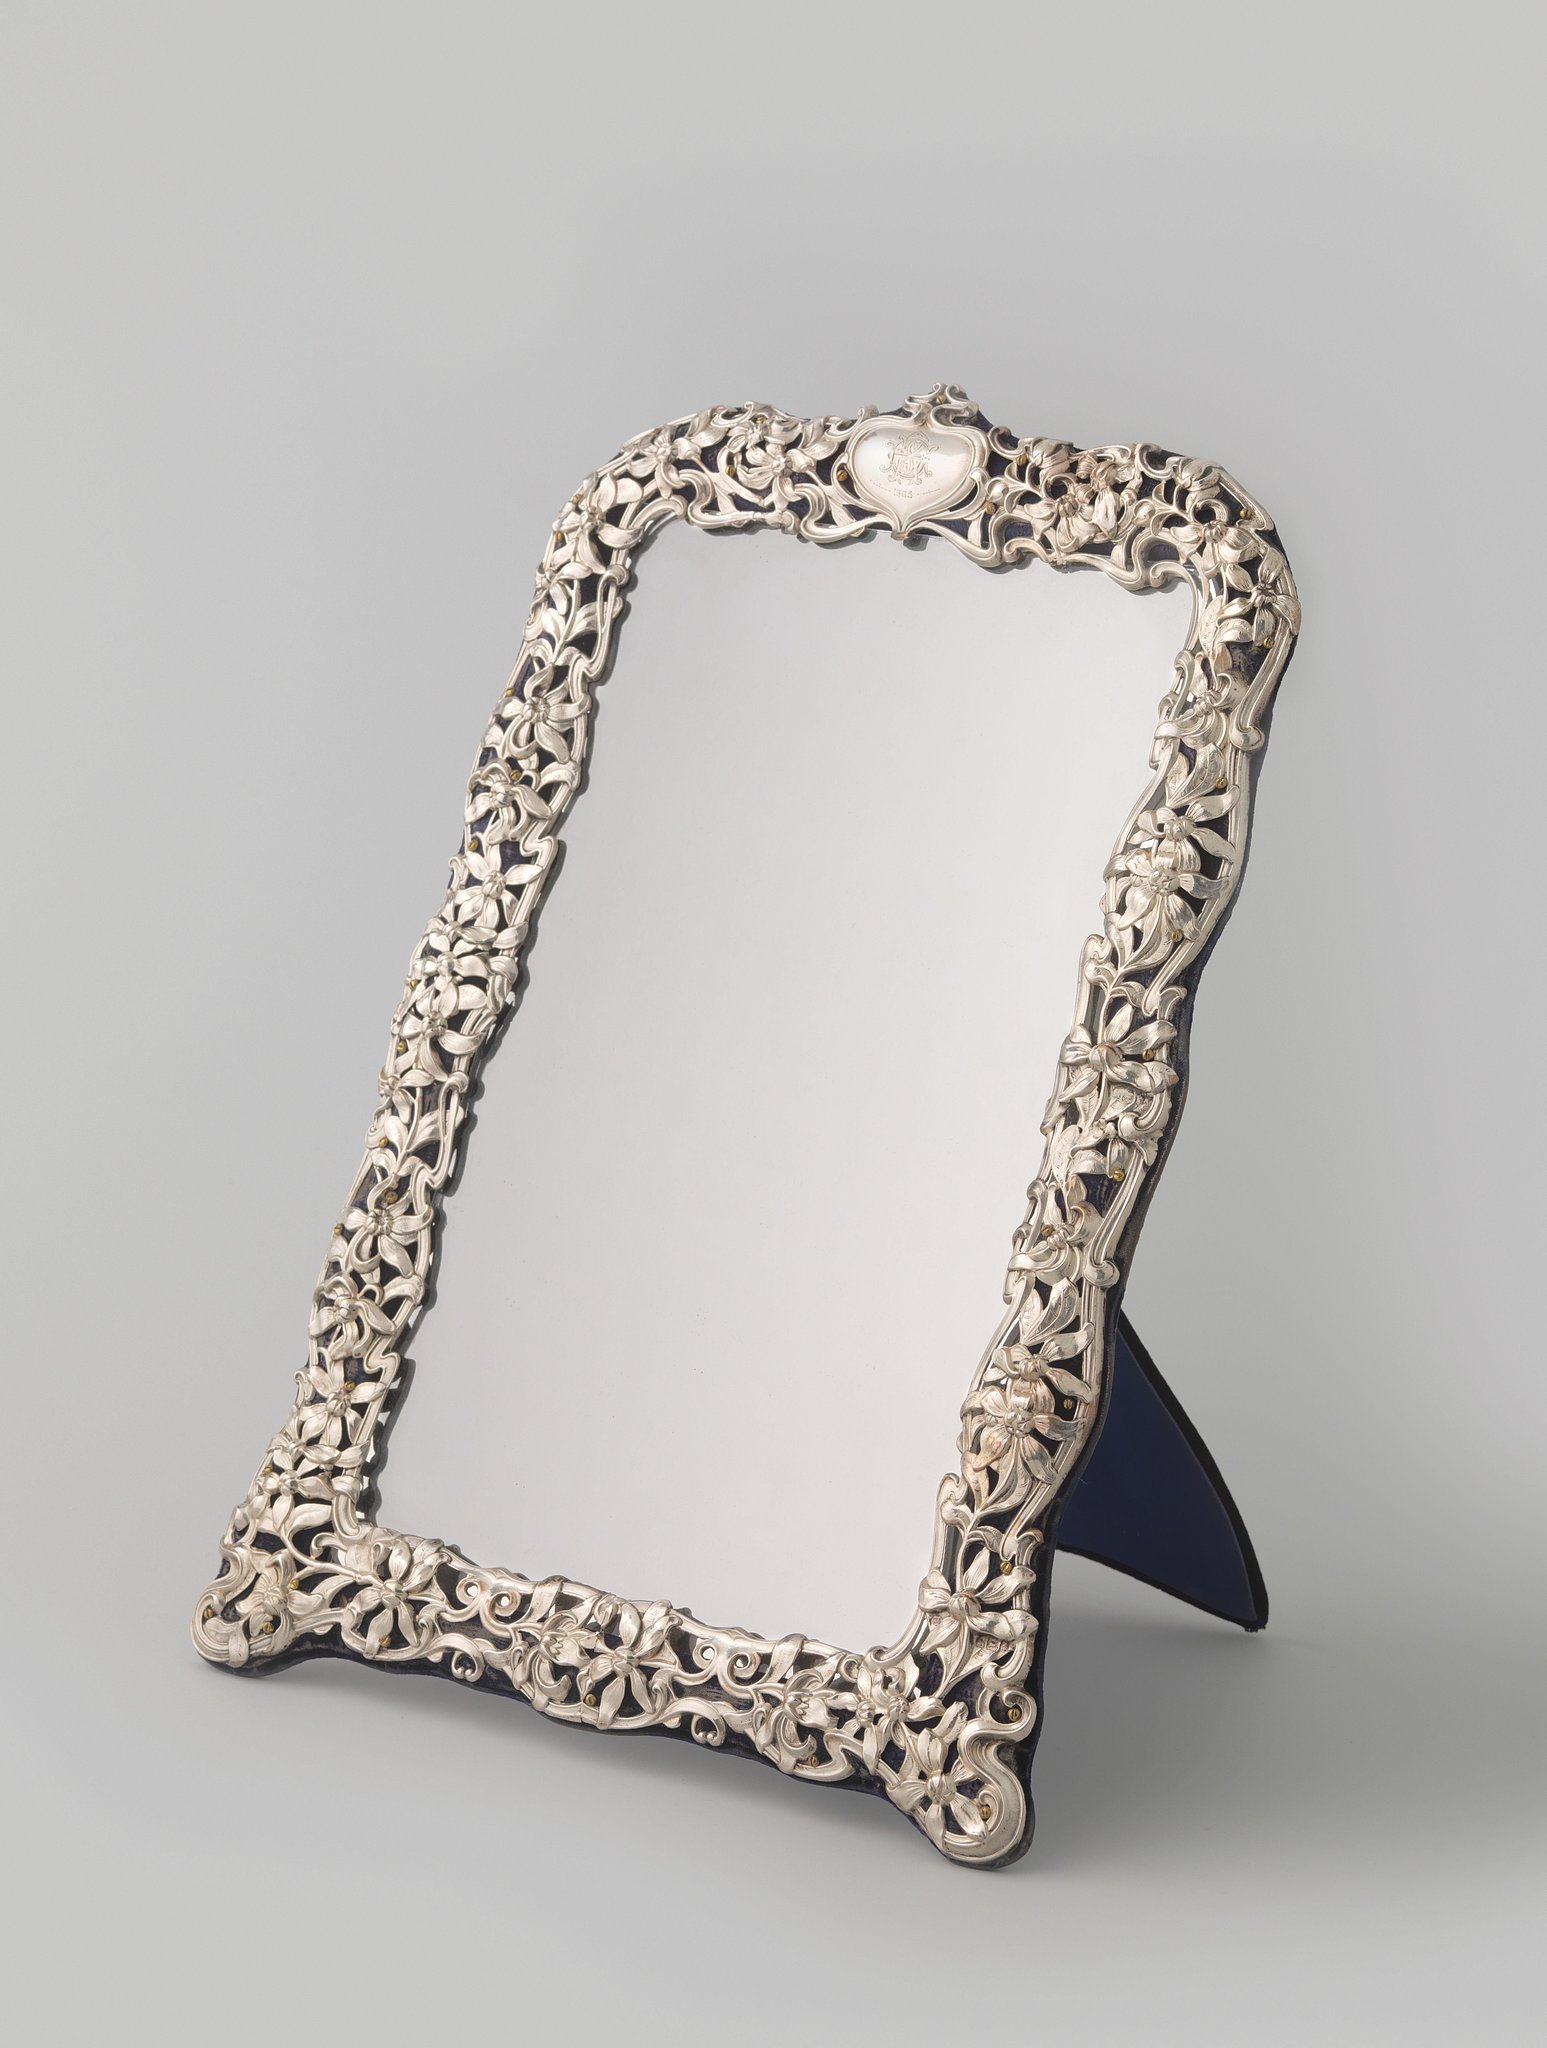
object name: mirror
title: Spiegel in een lijst van zilver die is opengewerkt met stengels en bloemen. In een cartouche een monogram uit de letters E R S, en het jaartal 1903.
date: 1903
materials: amalgam, glass, silver, velvet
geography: london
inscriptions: date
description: Spiegel in een zilveren lijst, die is opengewerkt en voornamelijk bestaat uit stengels en bloemen. In een cartouche een monogram uit de letters E R S, en jaartal 1903.